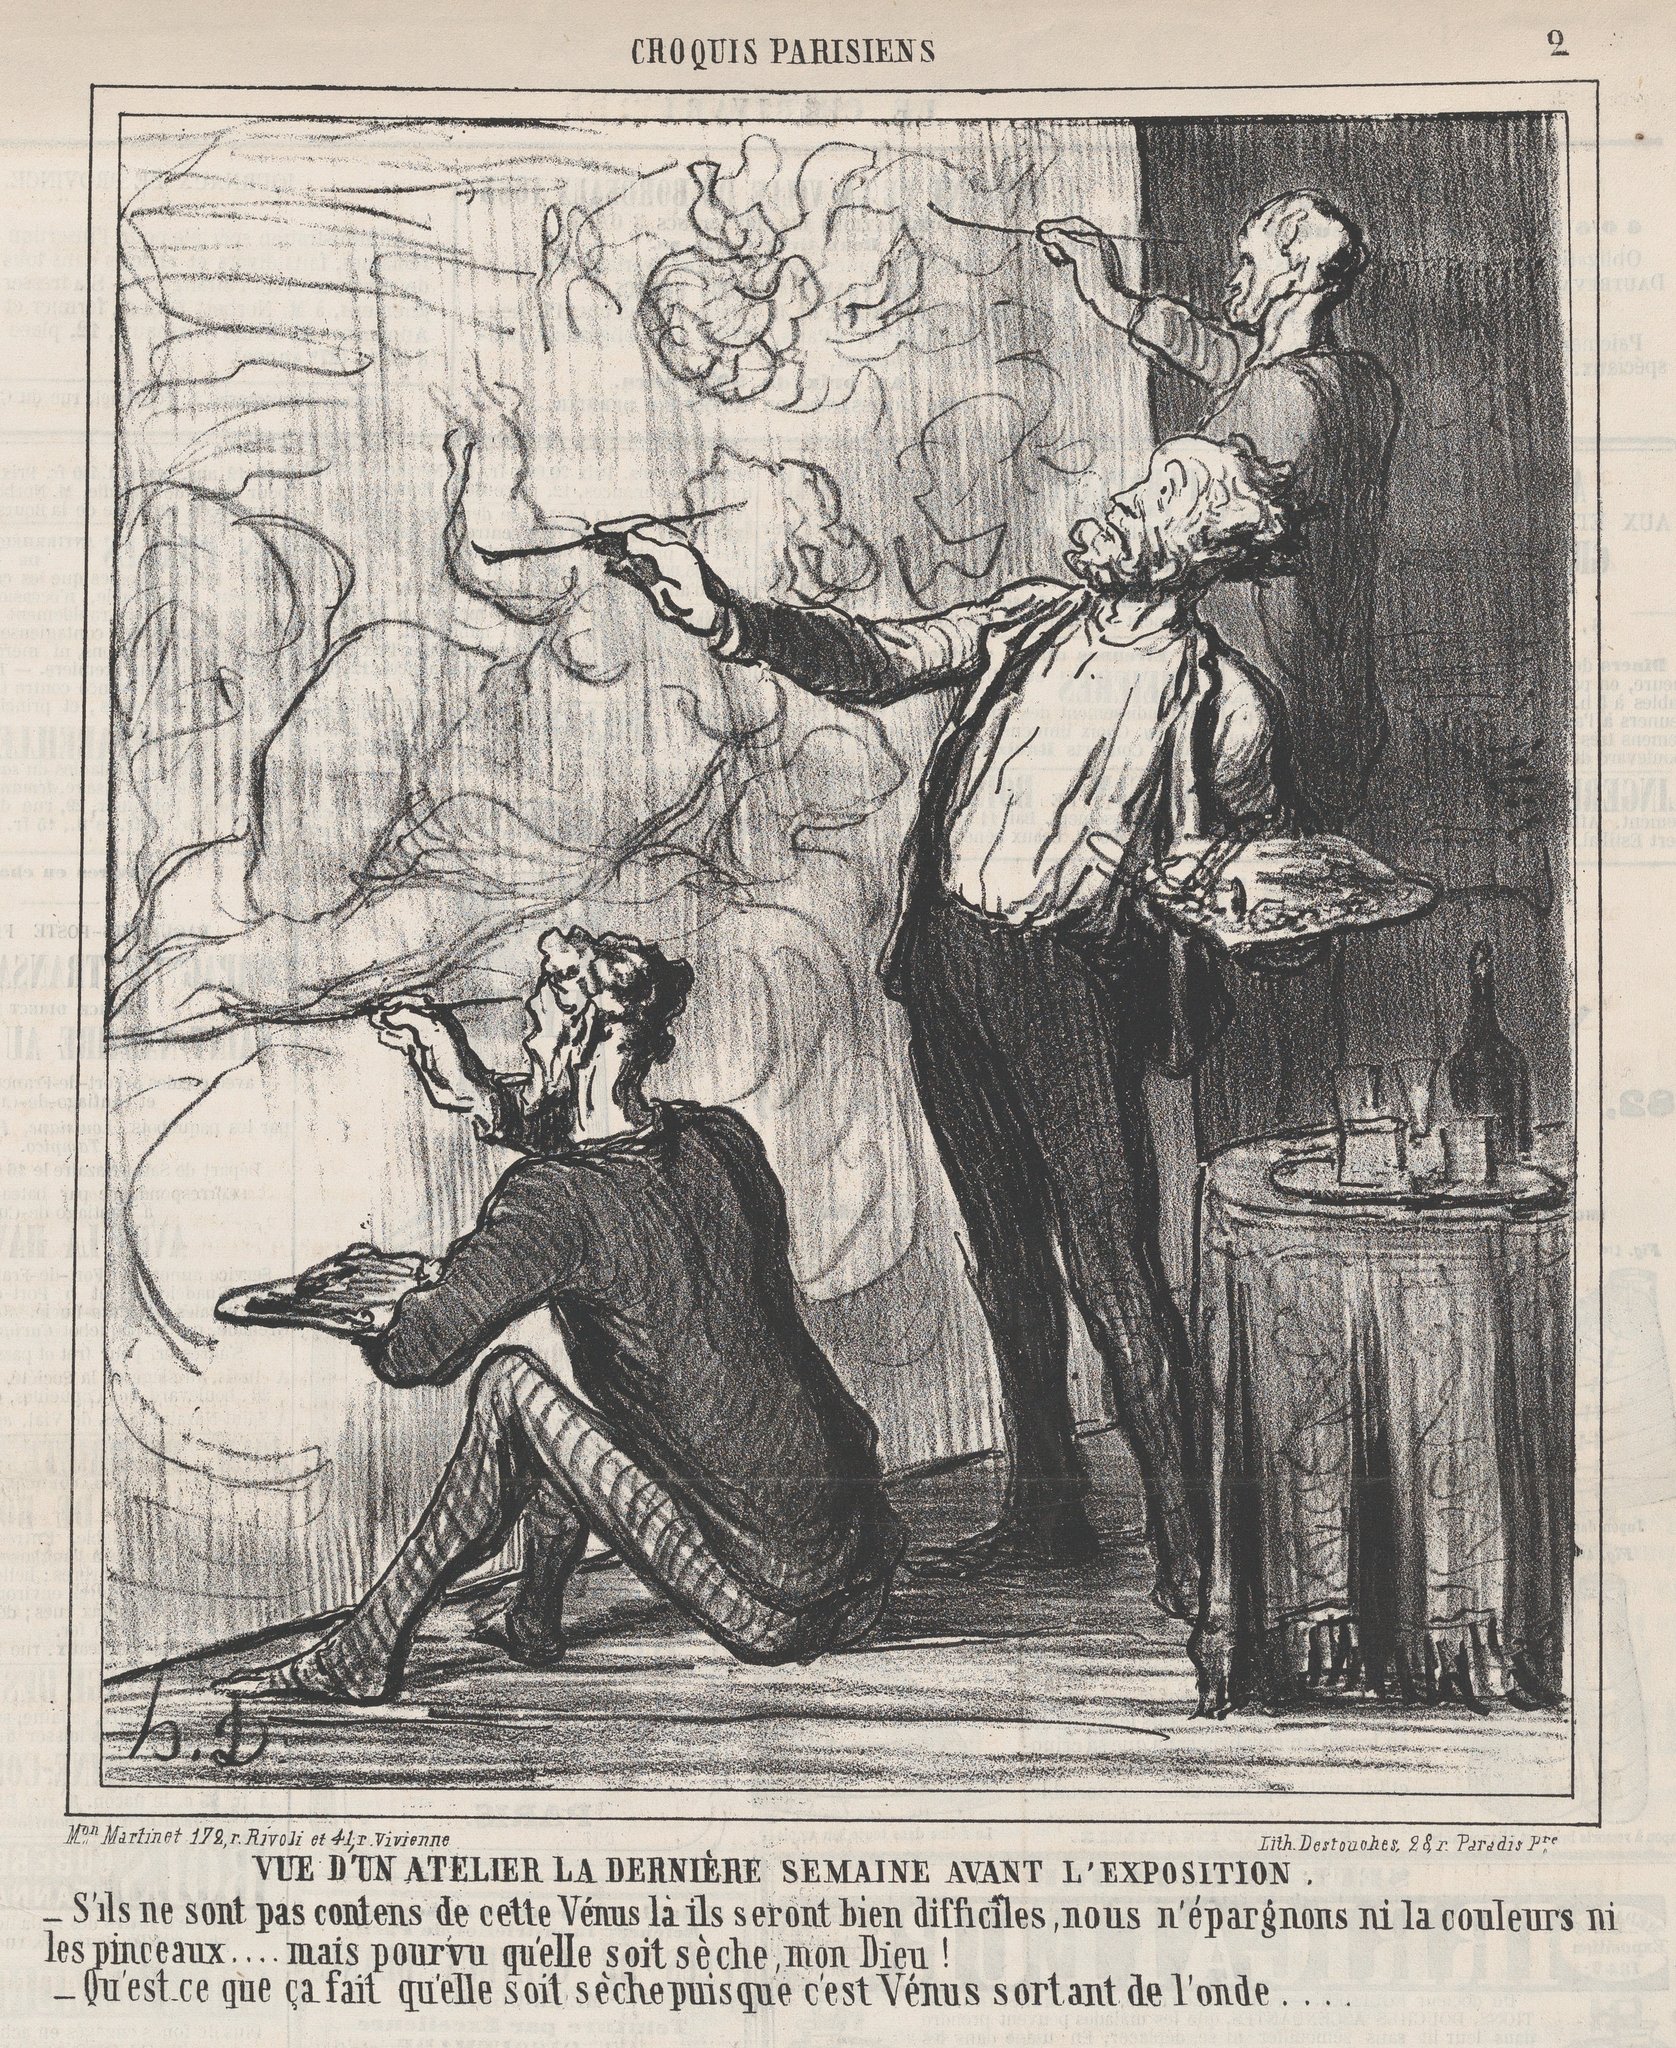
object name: print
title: View of a studio the final week before the exhibition, from 'Parisian sketches,' published in Le Charivari, April 1, 1864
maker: honoré daumier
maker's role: artist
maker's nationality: french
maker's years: 1808-1879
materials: paper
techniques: lithograph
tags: painting,satire,men,palettes